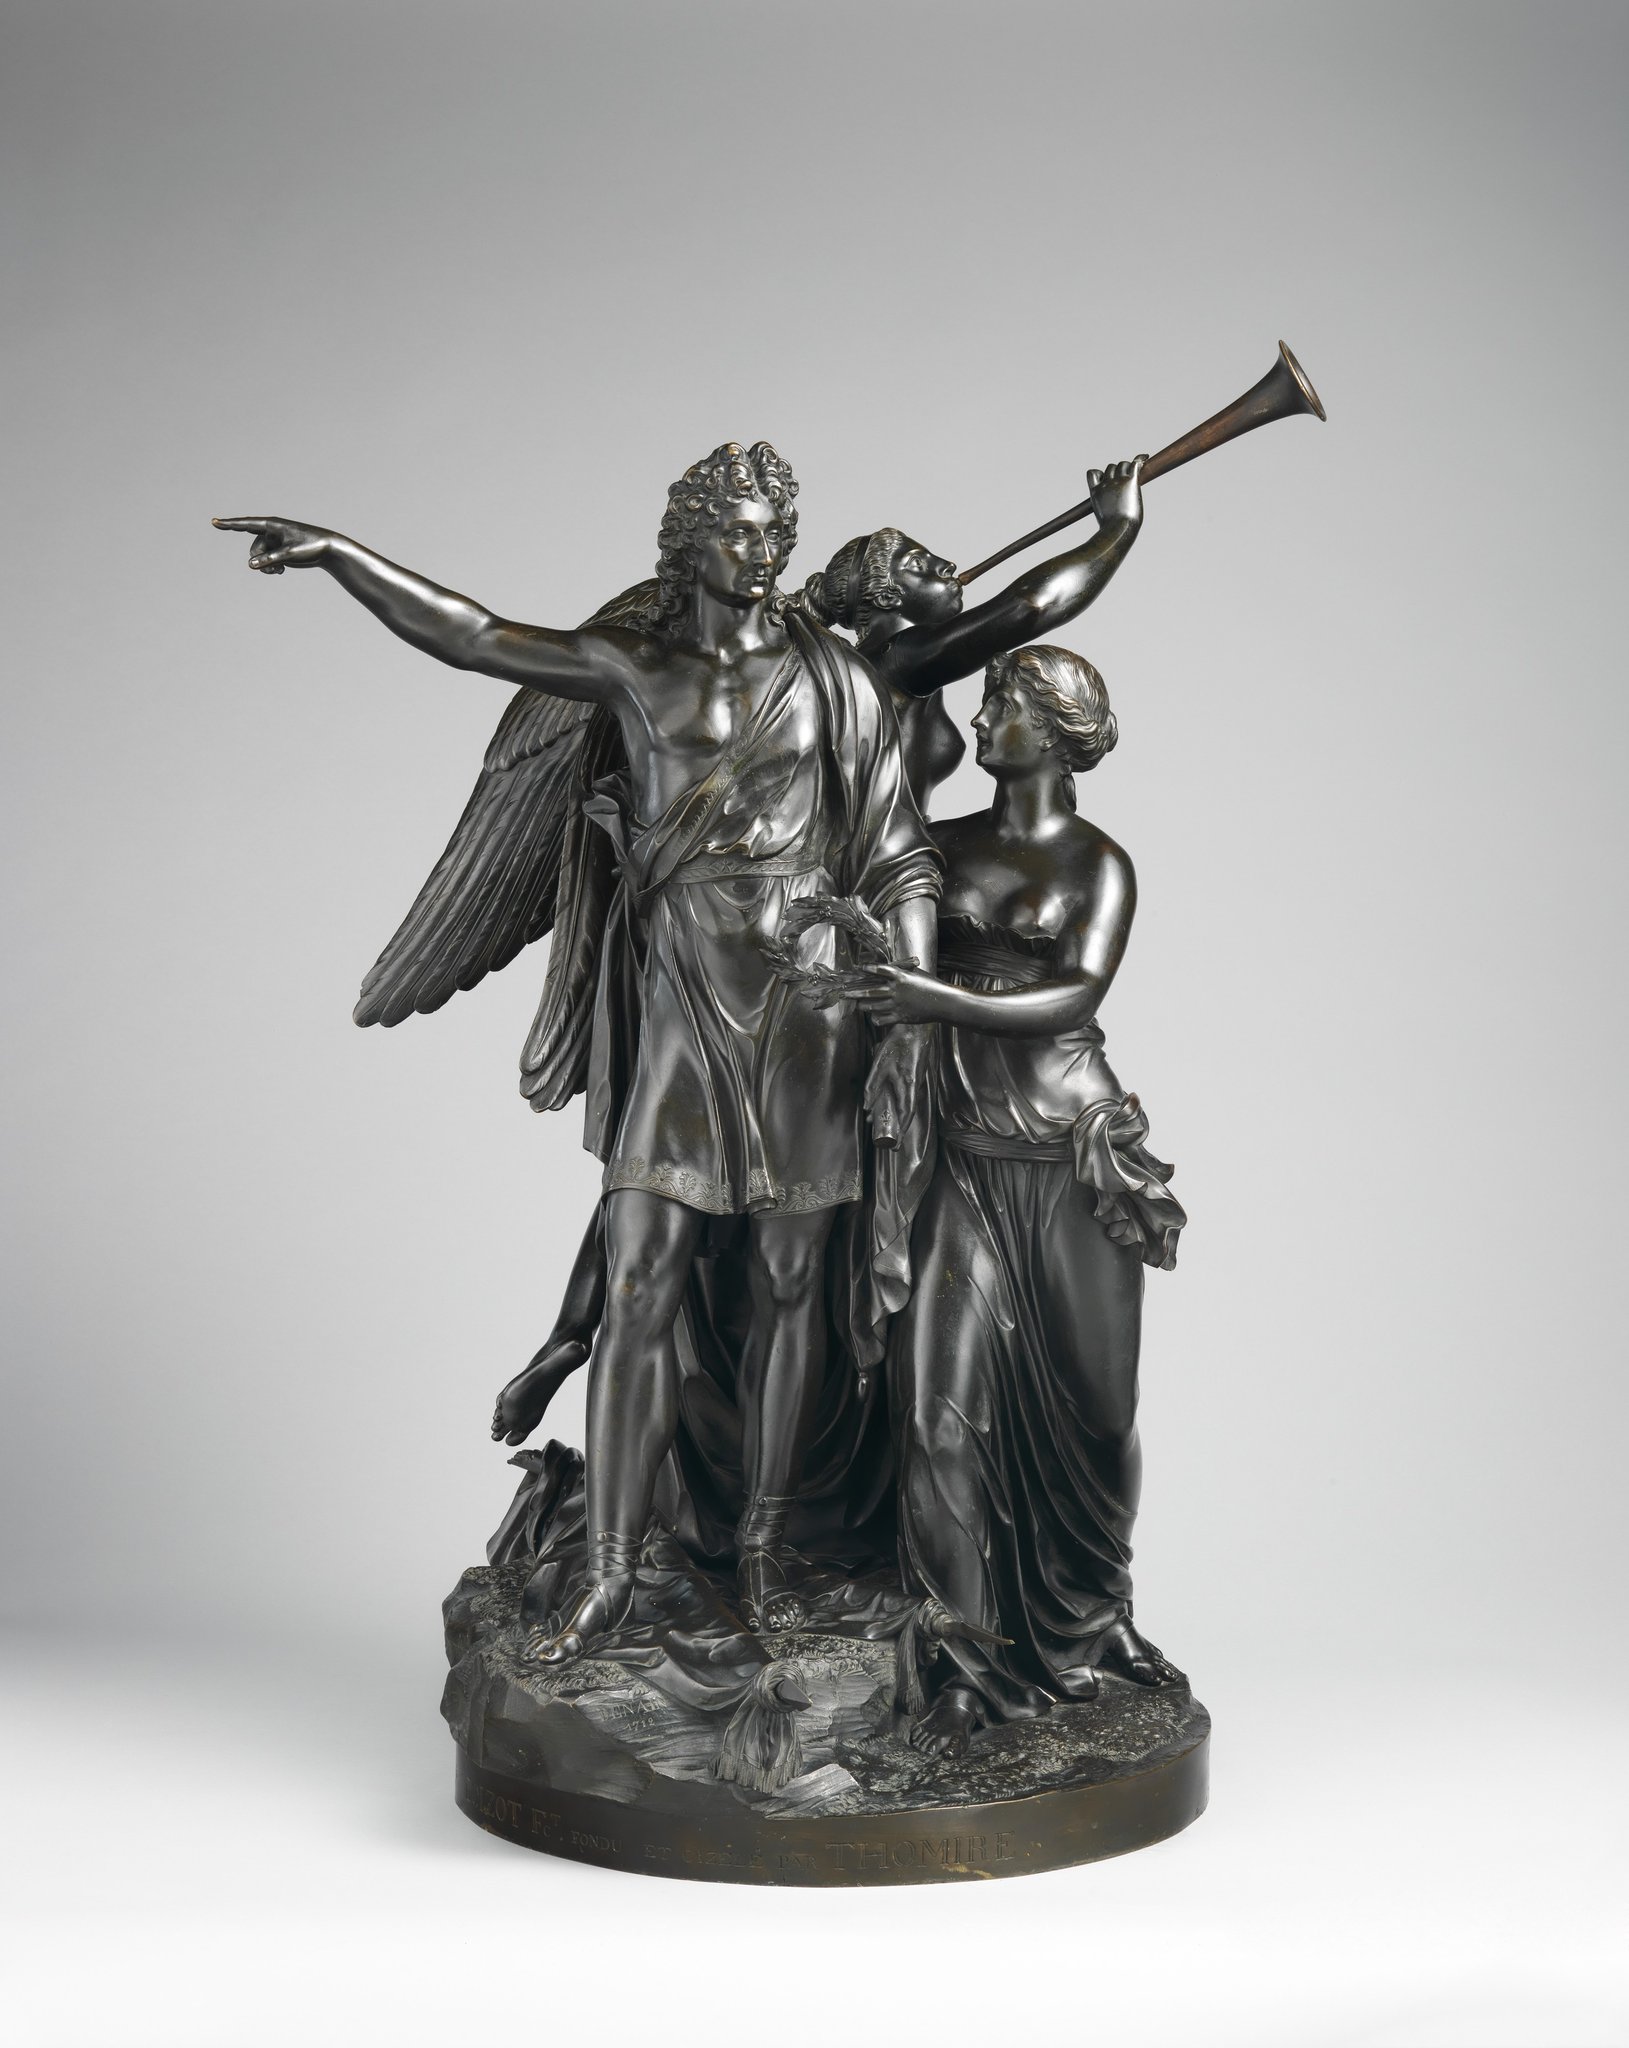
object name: group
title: Allegory of the Maréchal de Villars’s Victory at Denain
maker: louis simon boizot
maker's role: artist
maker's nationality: french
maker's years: 1743-1809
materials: bronze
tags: musical instruments,men,women,allegory